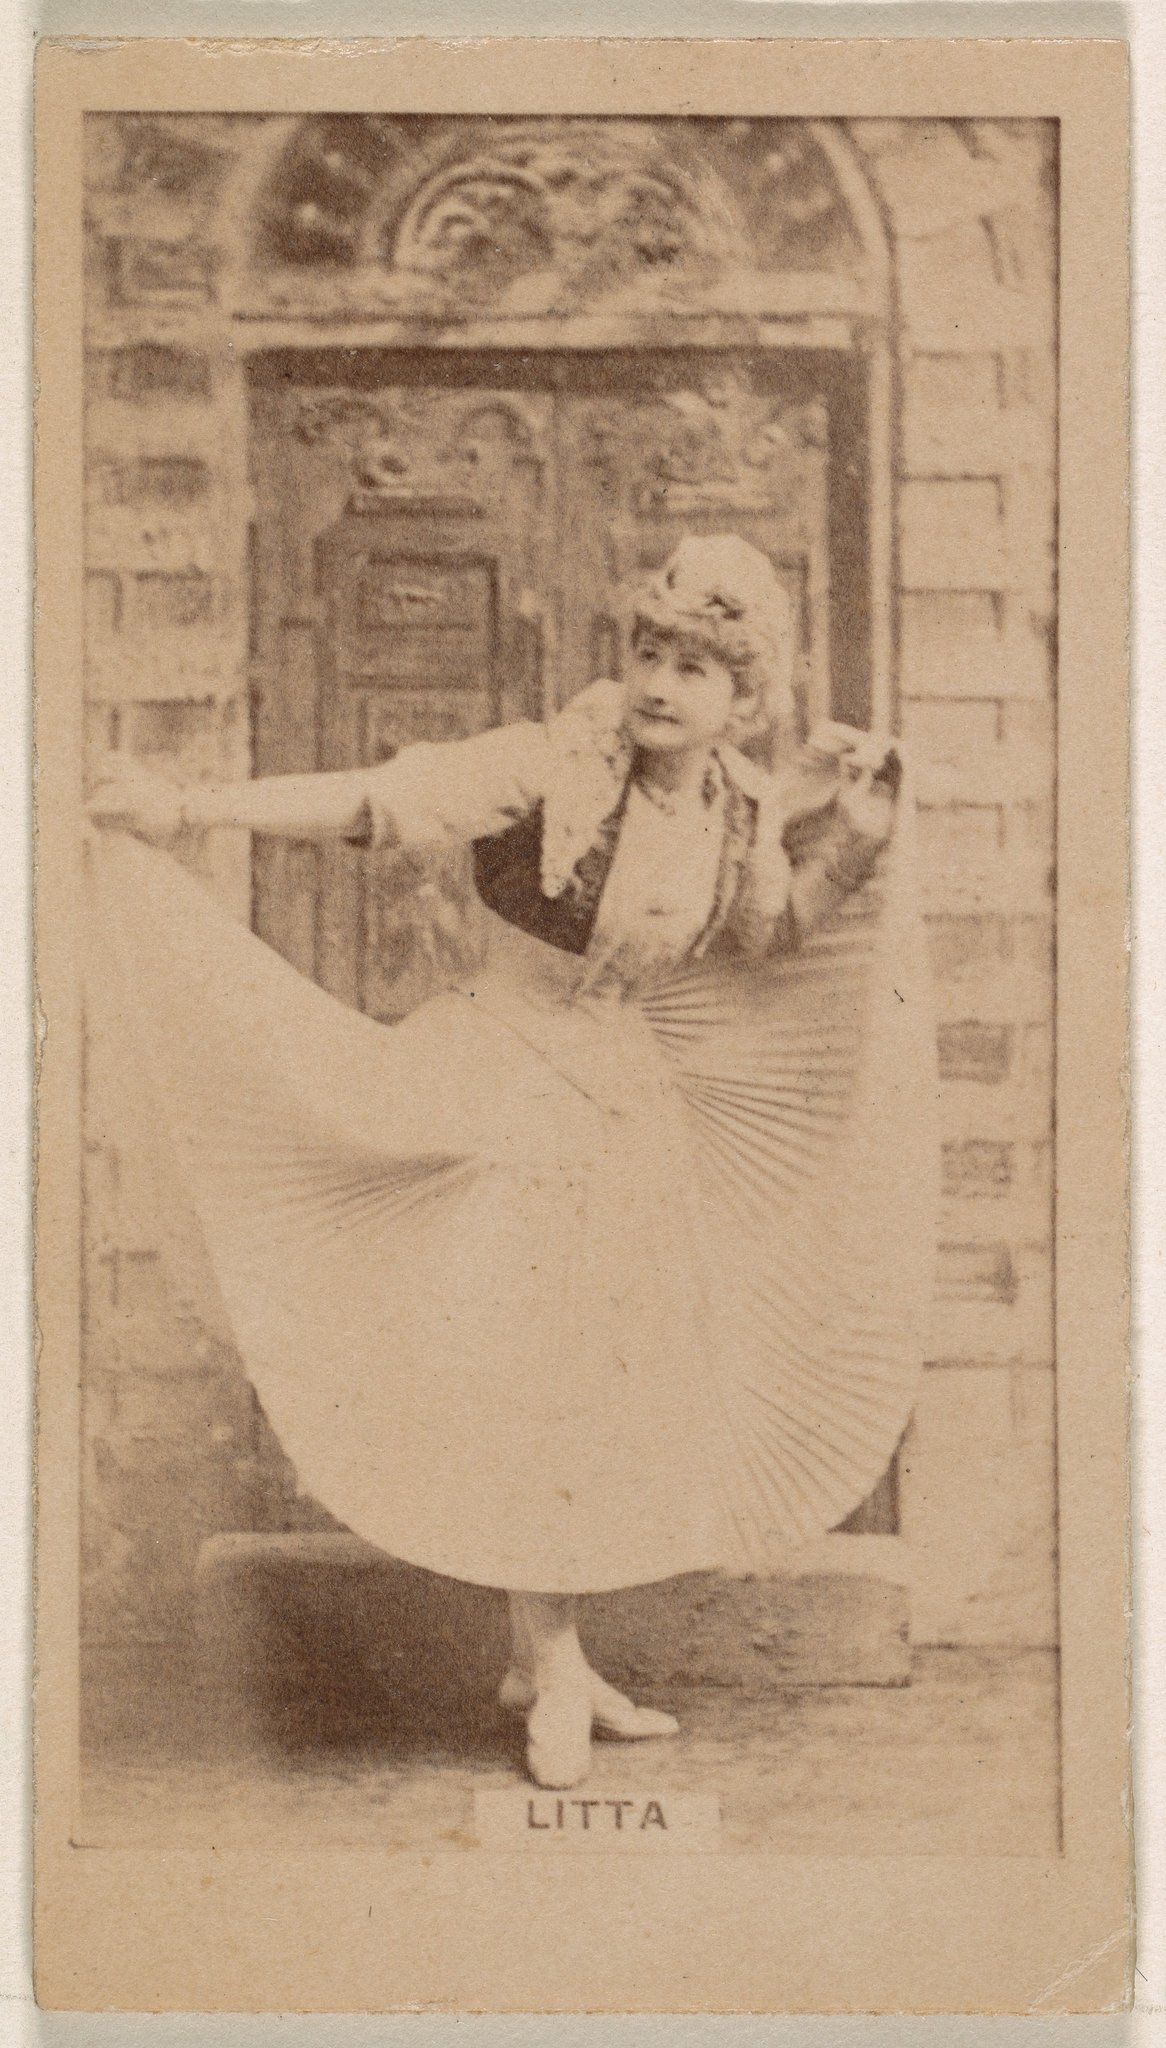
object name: photograph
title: Litta, from the Actresses series (N245) issued by Kinney Brothers to promote Sweet Caporal Cigarettes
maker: kinney brothers tobacco company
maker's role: publisher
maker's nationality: american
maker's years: 1869-2011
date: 1890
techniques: albumen silver print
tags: portraits,women,actresses